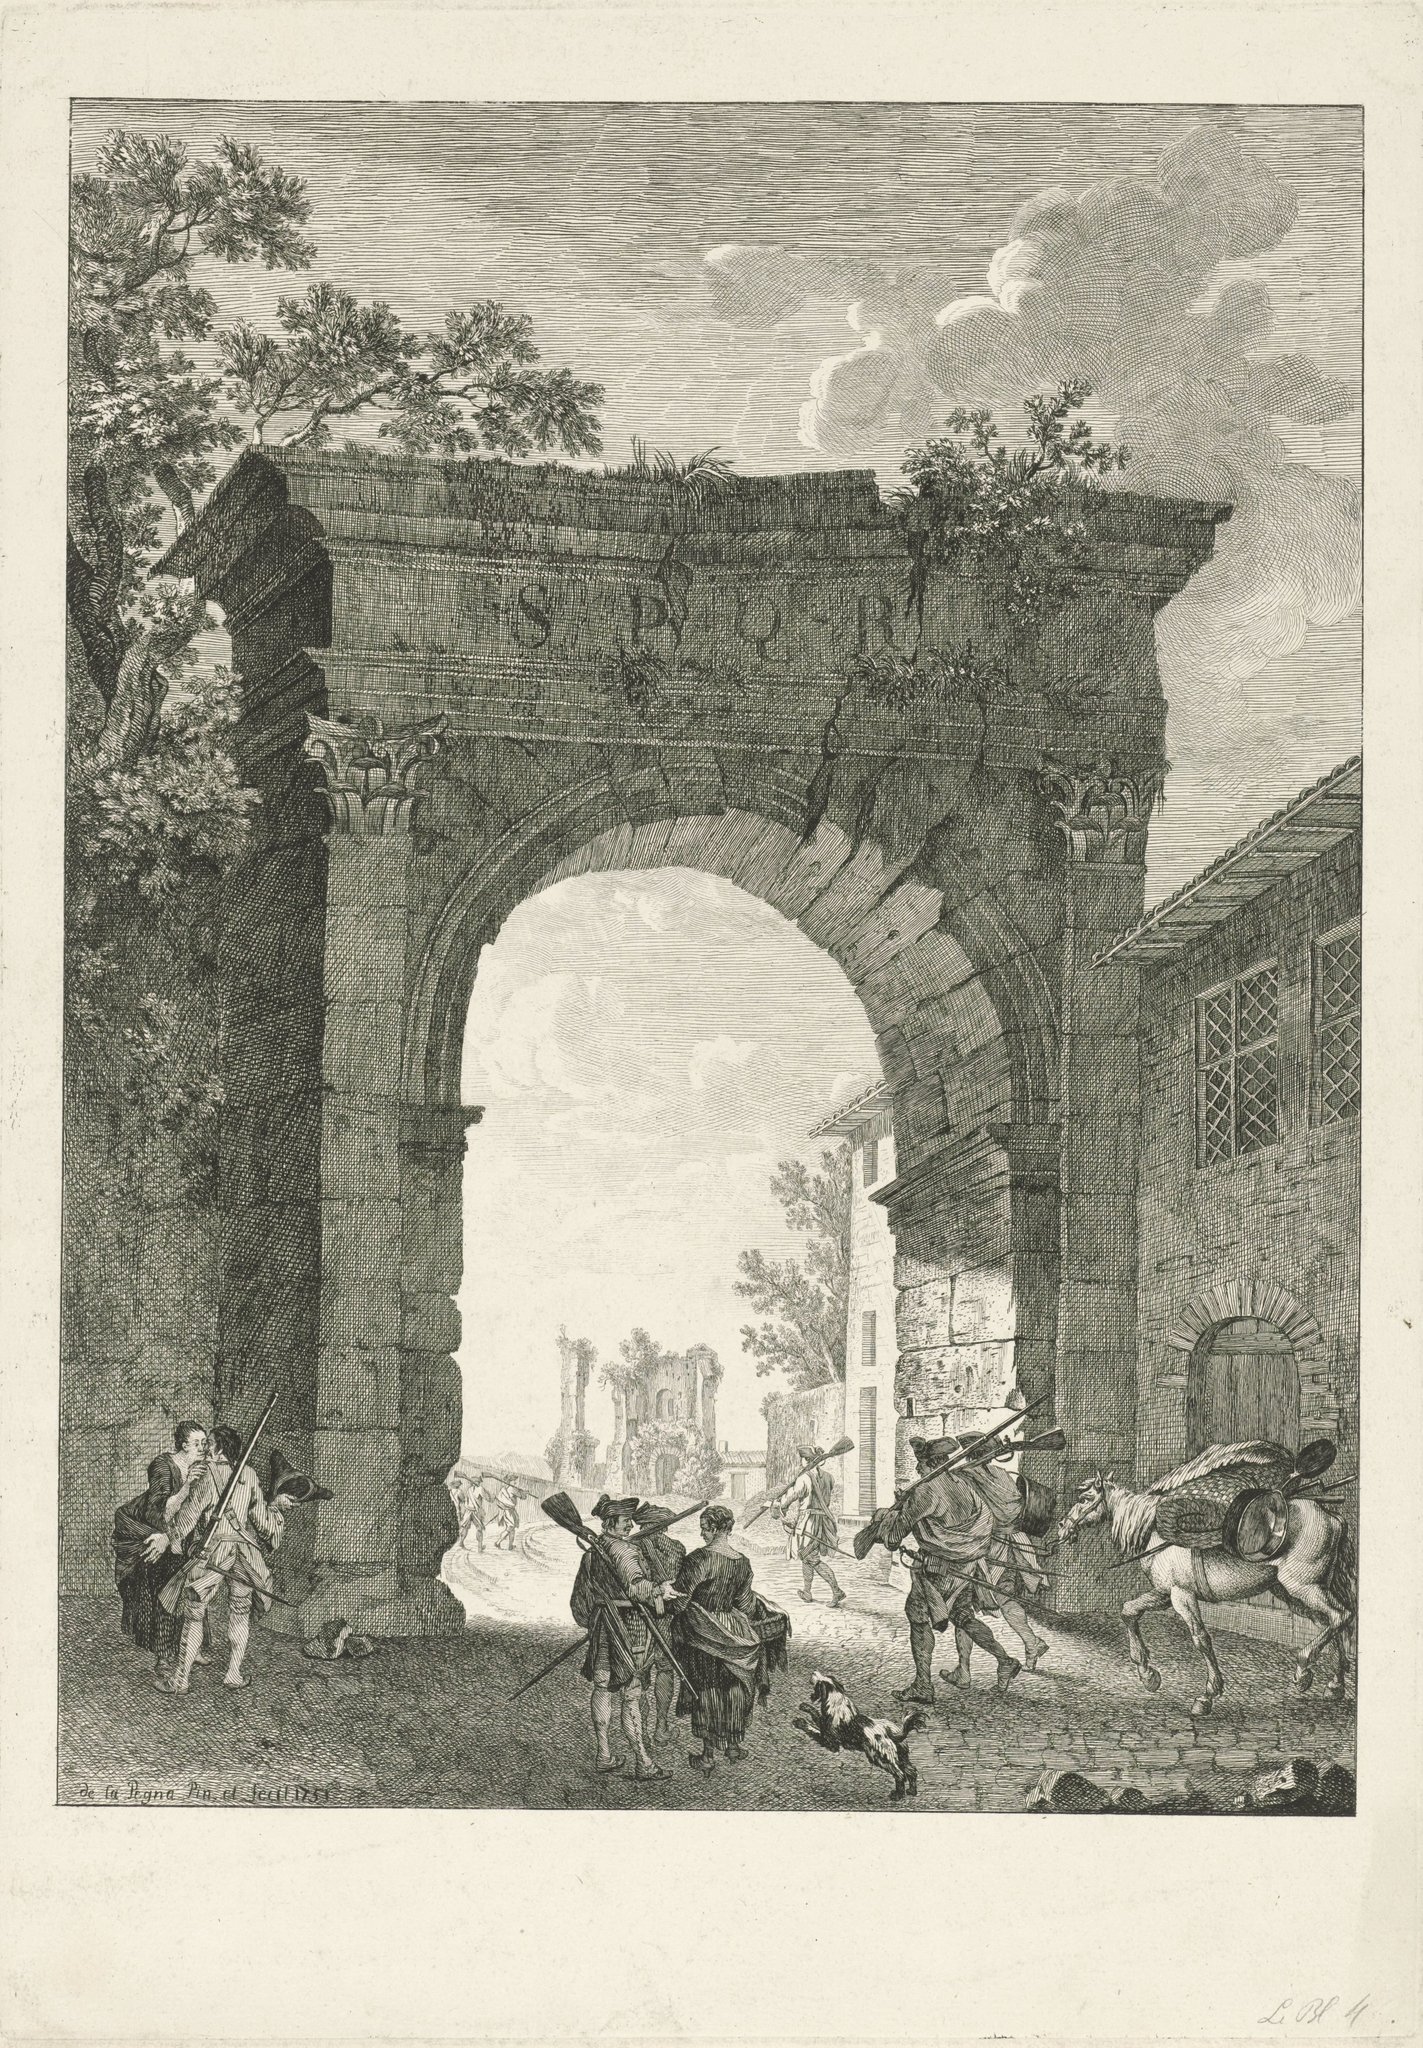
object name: print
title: Soldaten bij een stadspoort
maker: hyacinth de la pegna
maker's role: print maker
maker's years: 1706-1772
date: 1751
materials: paper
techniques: etching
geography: rome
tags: (lovers) kissing each other, soldiers and civilians, city-gate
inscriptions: collector's mark: Lugt 2228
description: Soldaten bij een Romeinse stadspoort, op de achtergrond een ruïne. Links op de voorgrond een soldaat en een vrouw die elkaar stiekem kussen. Met een lege marge.